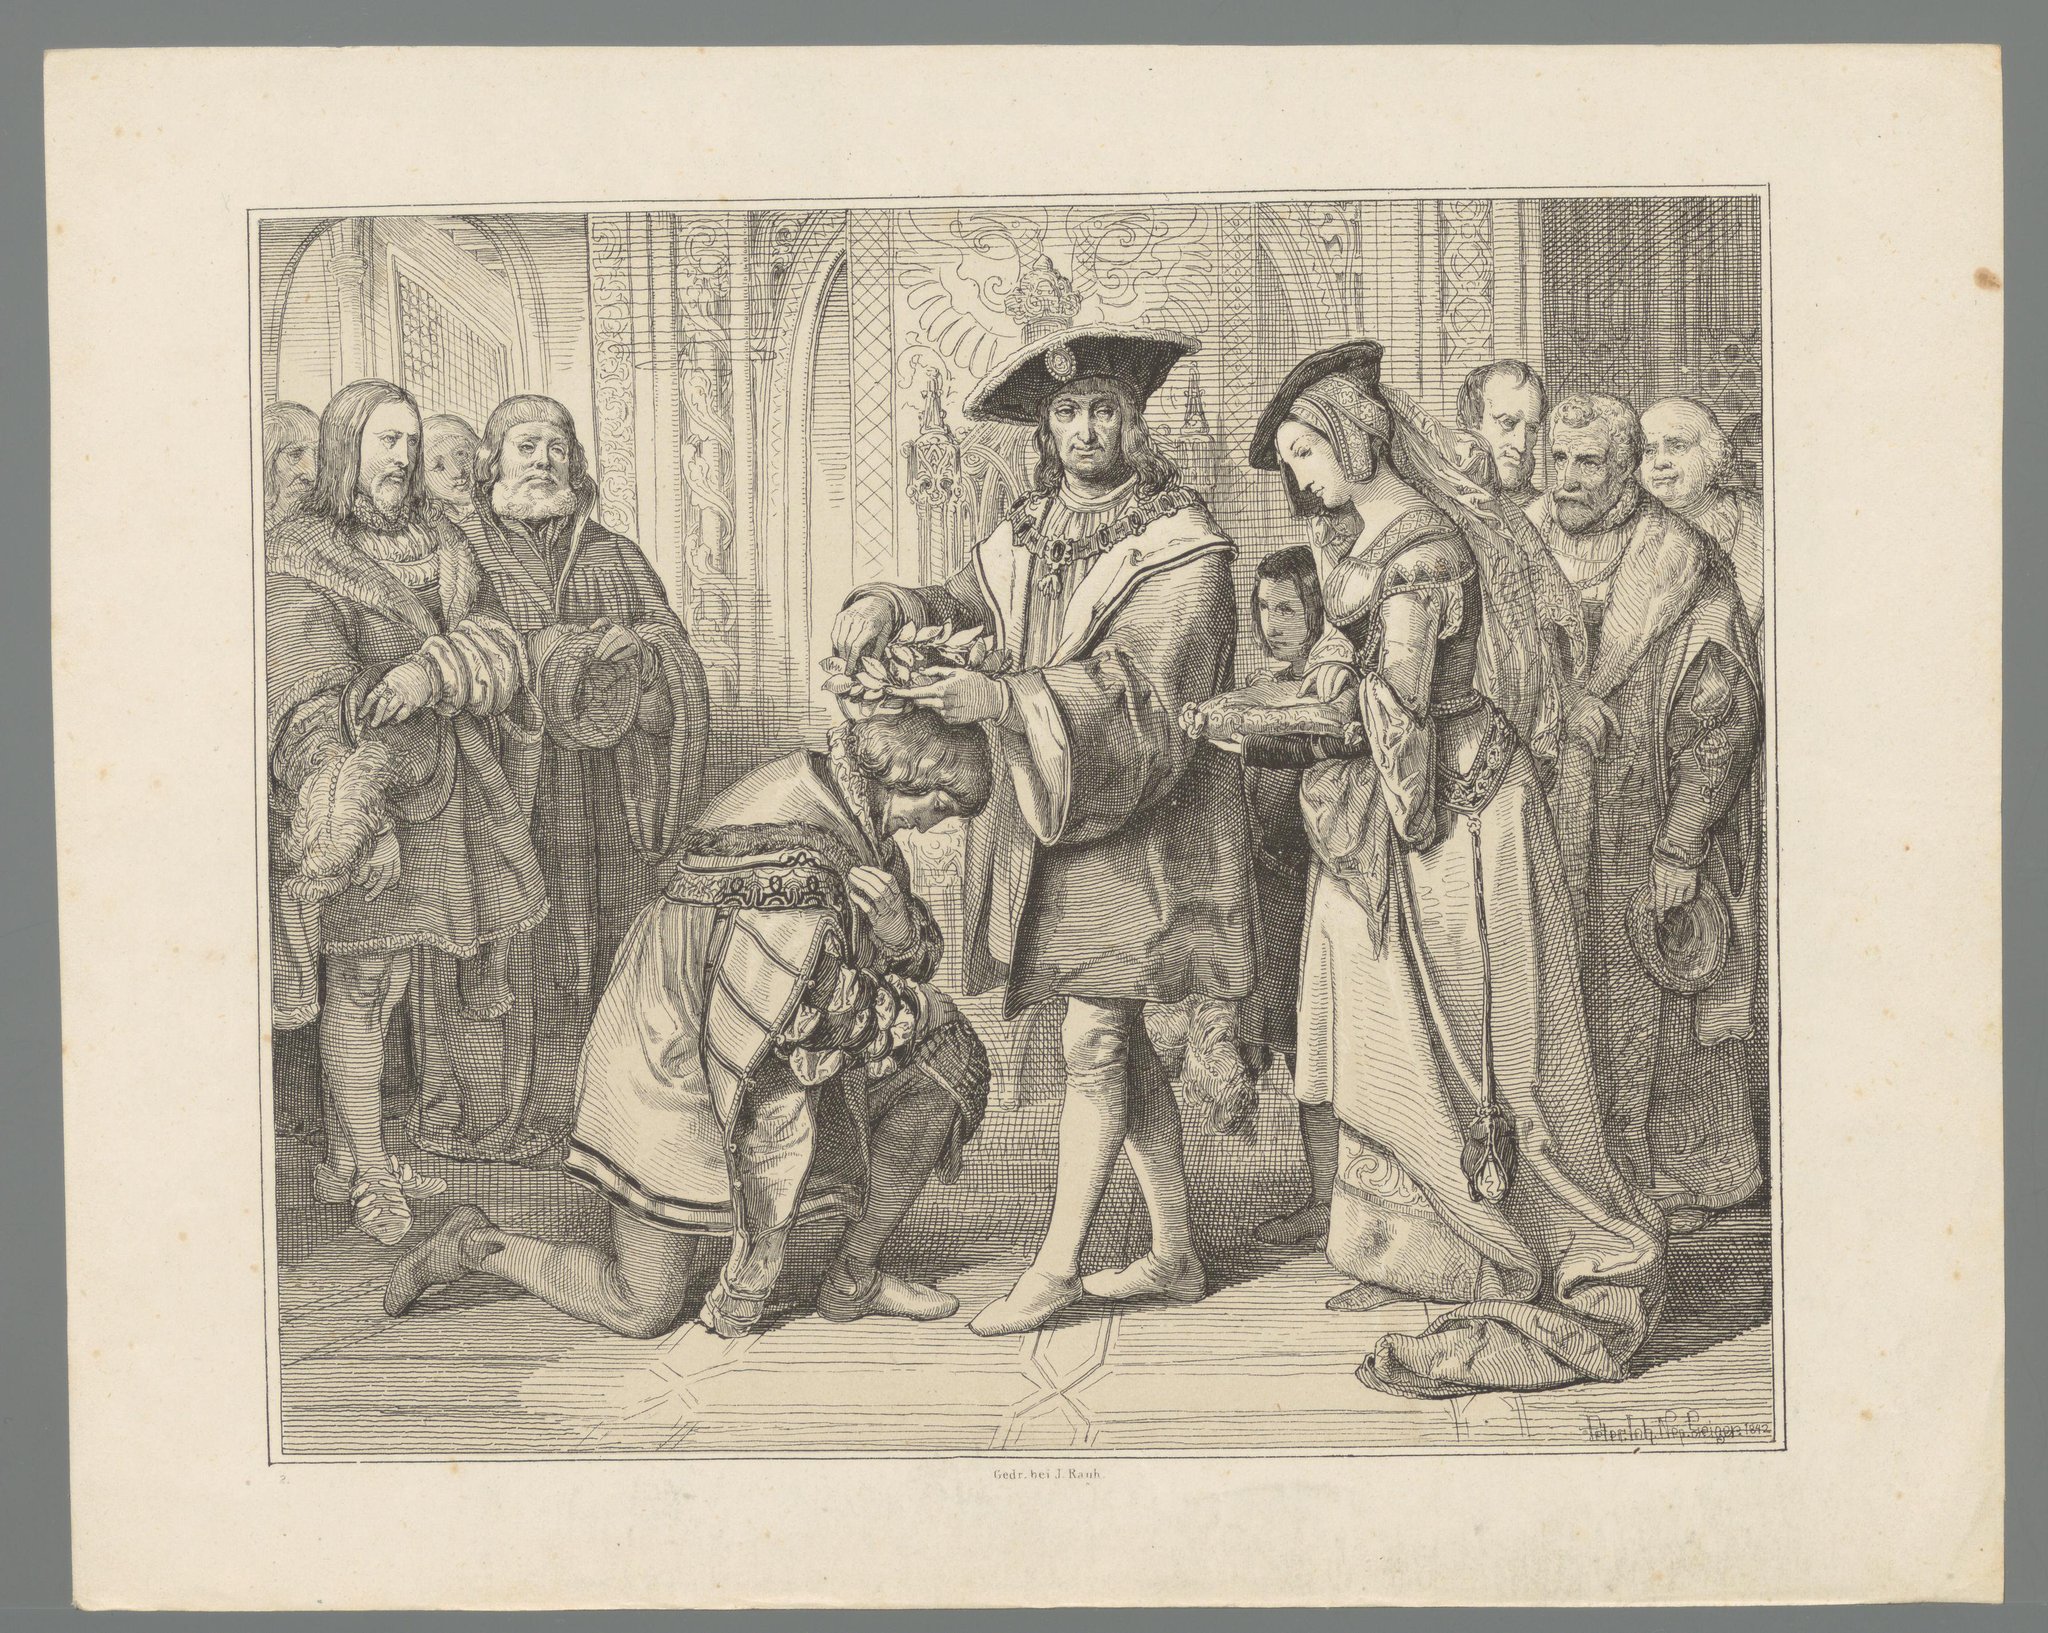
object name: print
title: Keizer kroont een dichter met een lauwerkrans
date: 1842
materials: paper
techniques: tone lithography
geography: vienna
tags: crowning with laurel, king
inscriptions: collector's mark: Lugt 2228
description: Prent maakt deel uit van een serie met historische taferelen. Over deze serie is verder niets bekend. Het betreft mogelijk scènes uit het leven van een koning/heilige.